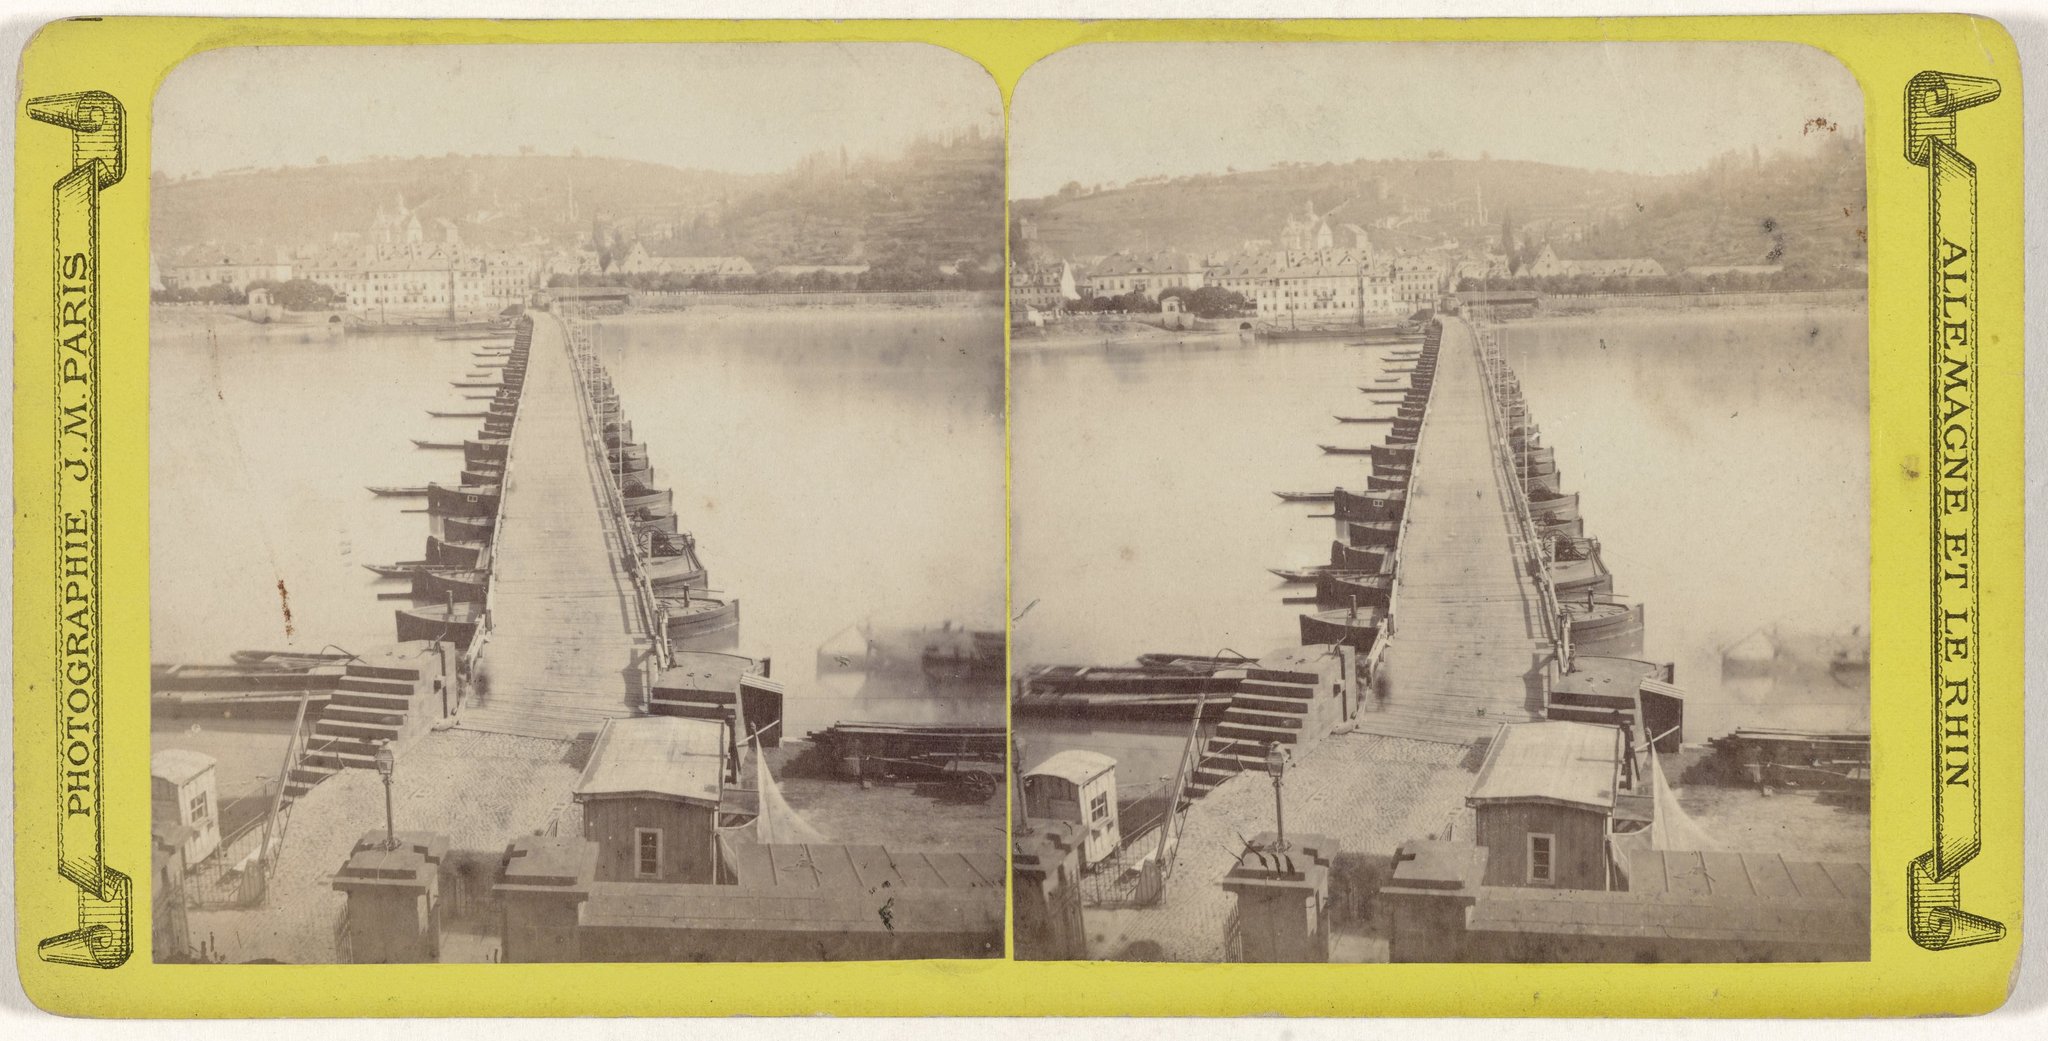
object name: stereograph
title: Allemagne et le Rhin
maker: jules marinier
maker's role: publisher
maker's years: 1823-1896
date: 1864-1880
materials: cardboard, paper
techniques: albumen print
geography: koblenz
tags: river, pontoon bridge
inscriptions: number: ‘25’